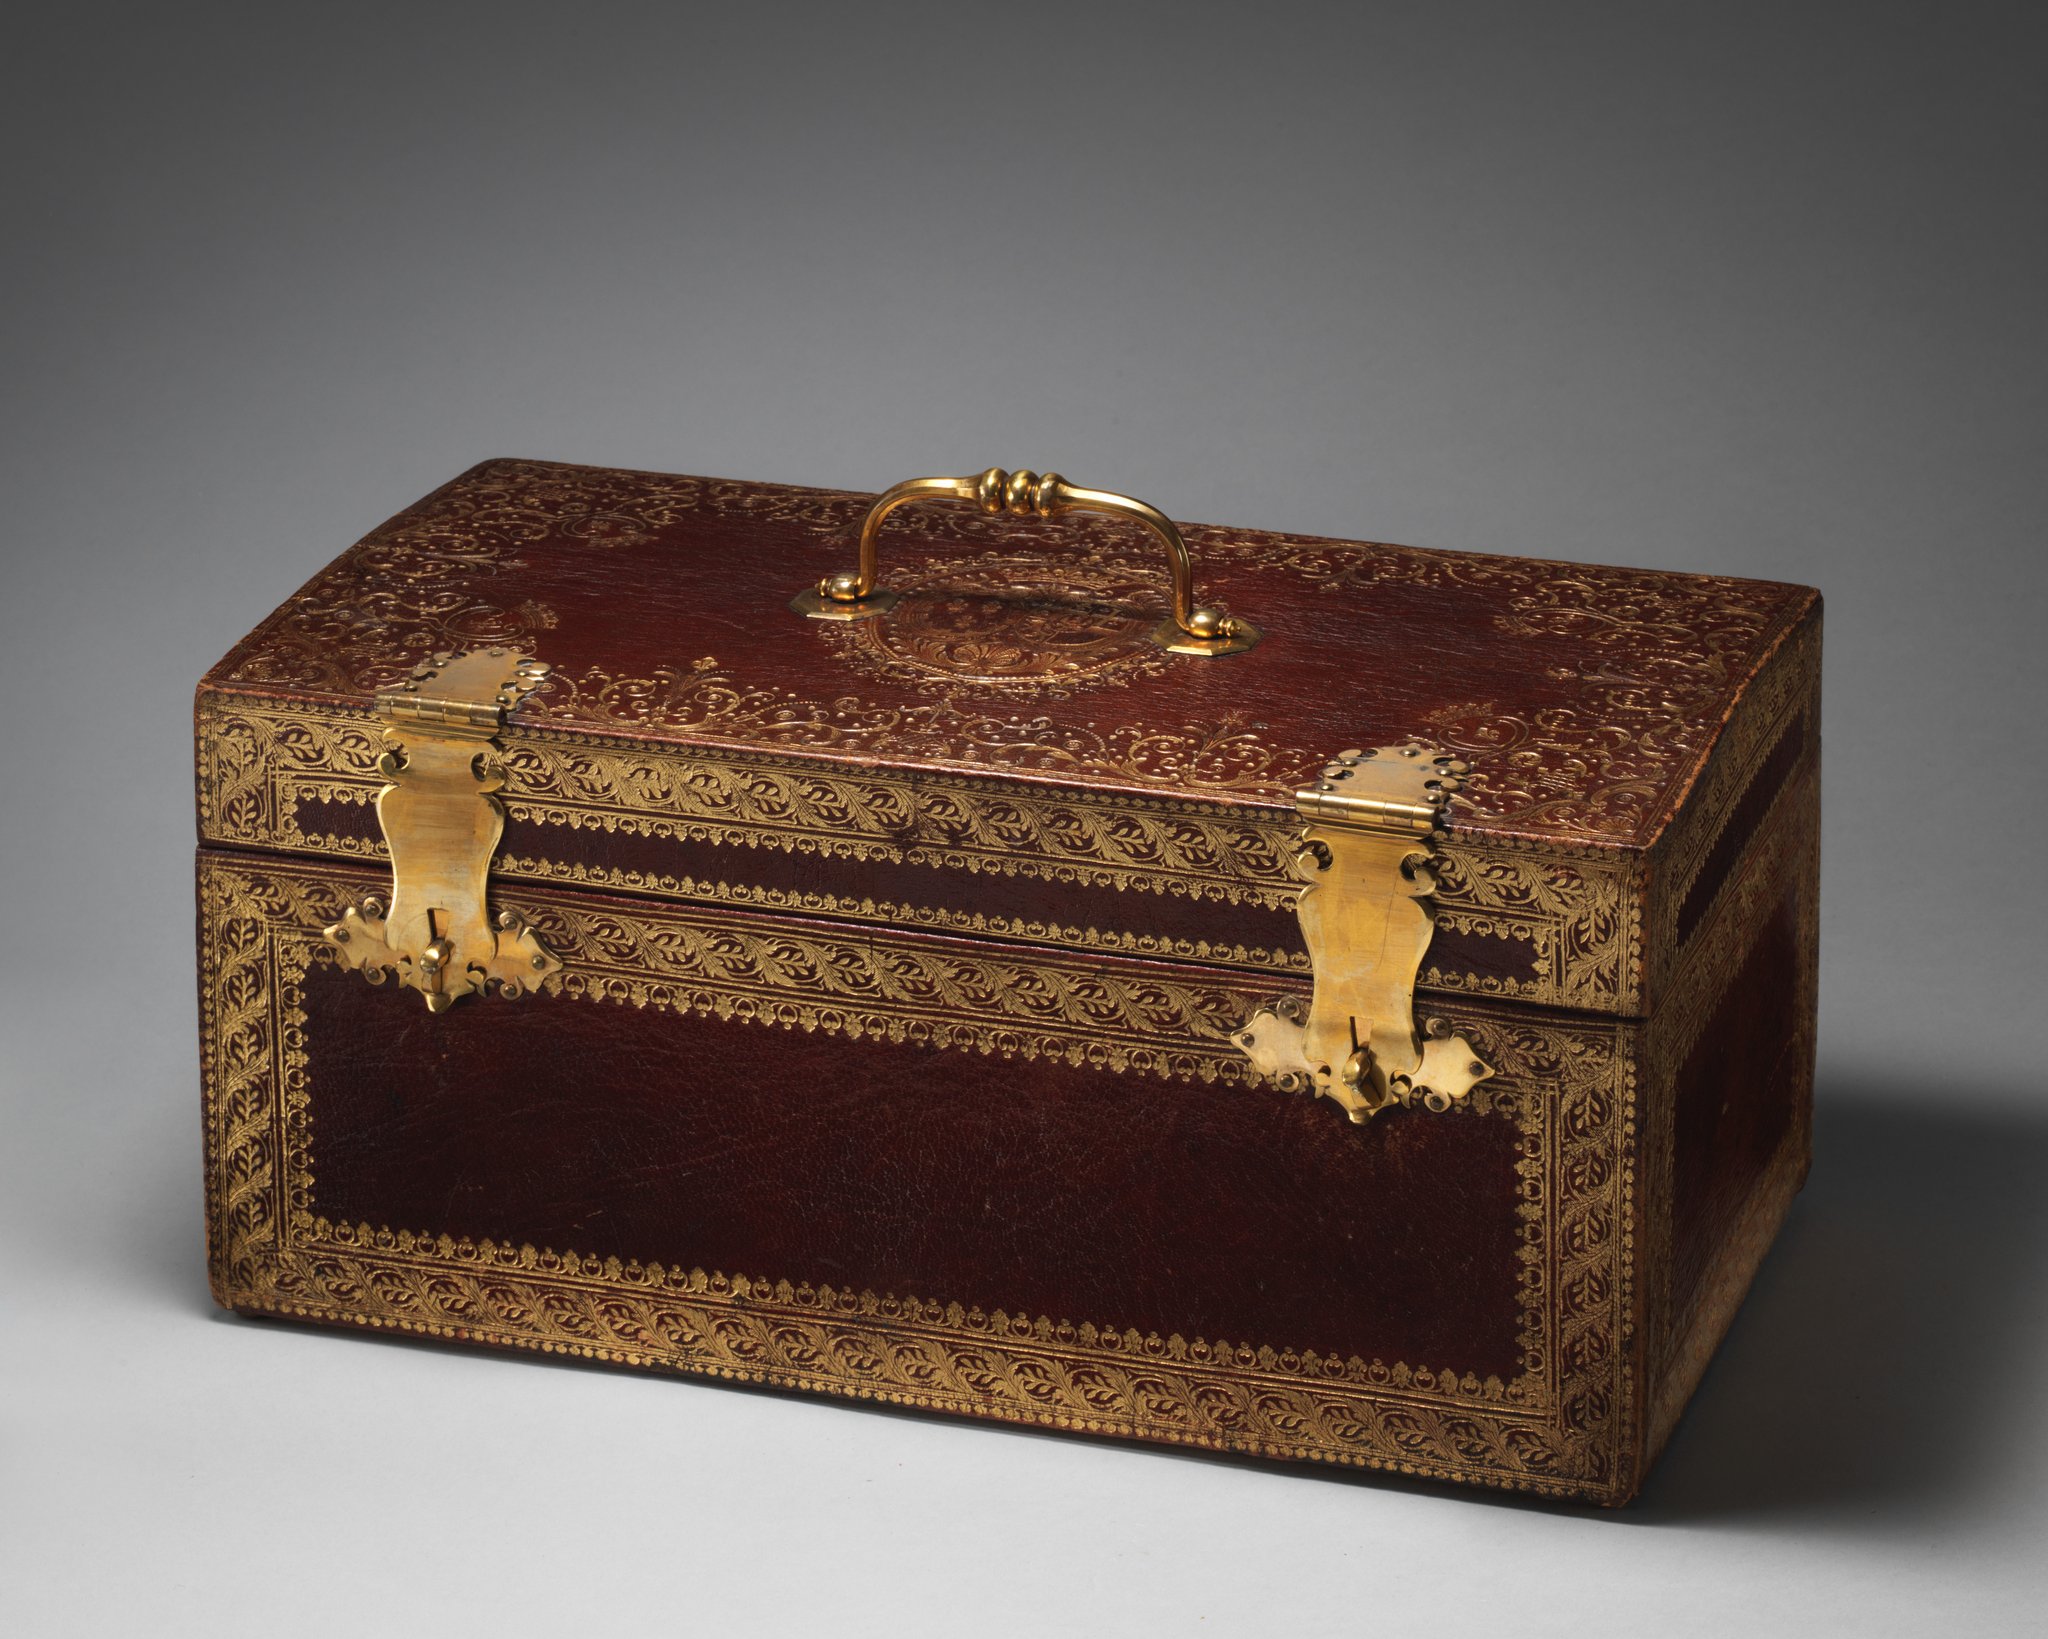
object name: coffer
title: Coffer stamped with the arms of Marie Thérèse of Savoy as the Countess of Artois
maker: les frères riollant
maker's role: maker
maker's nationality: french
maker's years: -1781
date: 1773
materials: brass, gilt, leather, metal, silk, wood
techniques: lining, tooling